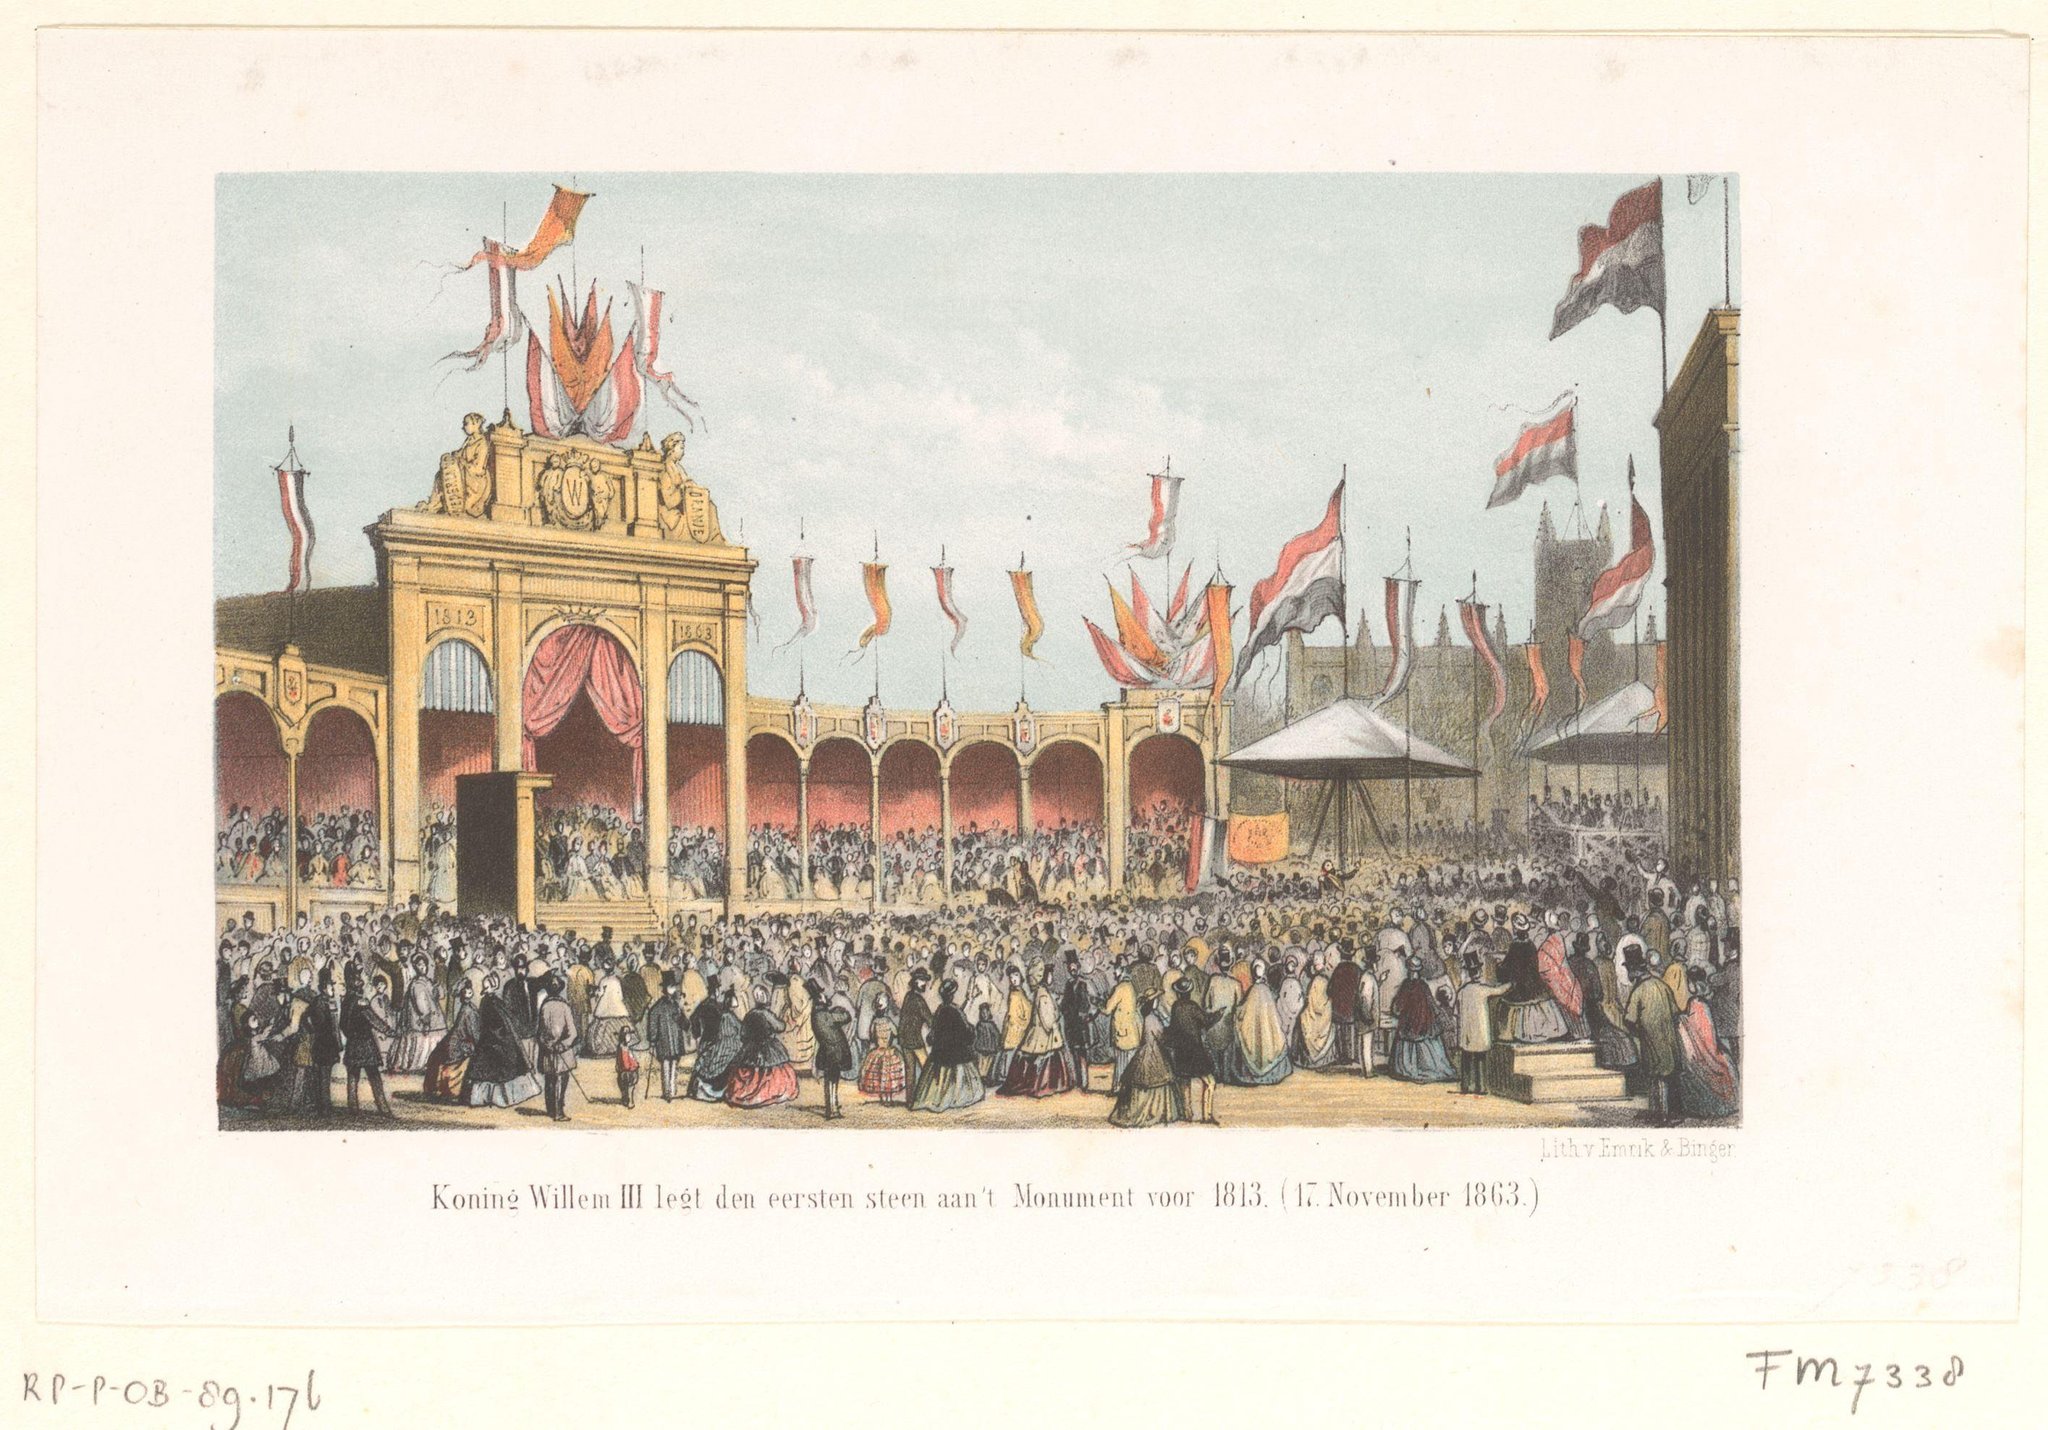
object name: print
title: Koning Willem III legt den eersten steen aan 't Monument voor 1813. (17 November 1863)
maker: Anonymous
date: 1863-1865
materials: paper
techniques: lithograph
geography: netherlands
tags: brussels, willem iii (koning der nederlanden), ceremonial laying of the foundations, laying the first stone, the hague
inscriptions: collector's mark: Lugt 2228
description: Ceremonie op 17 november 1863 van het leggen van de eerste steen door koning Willem III voor het monument ter nagedachtenis aan de onafhankelijkheid en de stichting van het Koninkrijk der Nederlanden in 1813, in het Willemspark (nu Plein 1813) te Den Haag. Gezicht op de opbouw met de tribune voor de gasten.